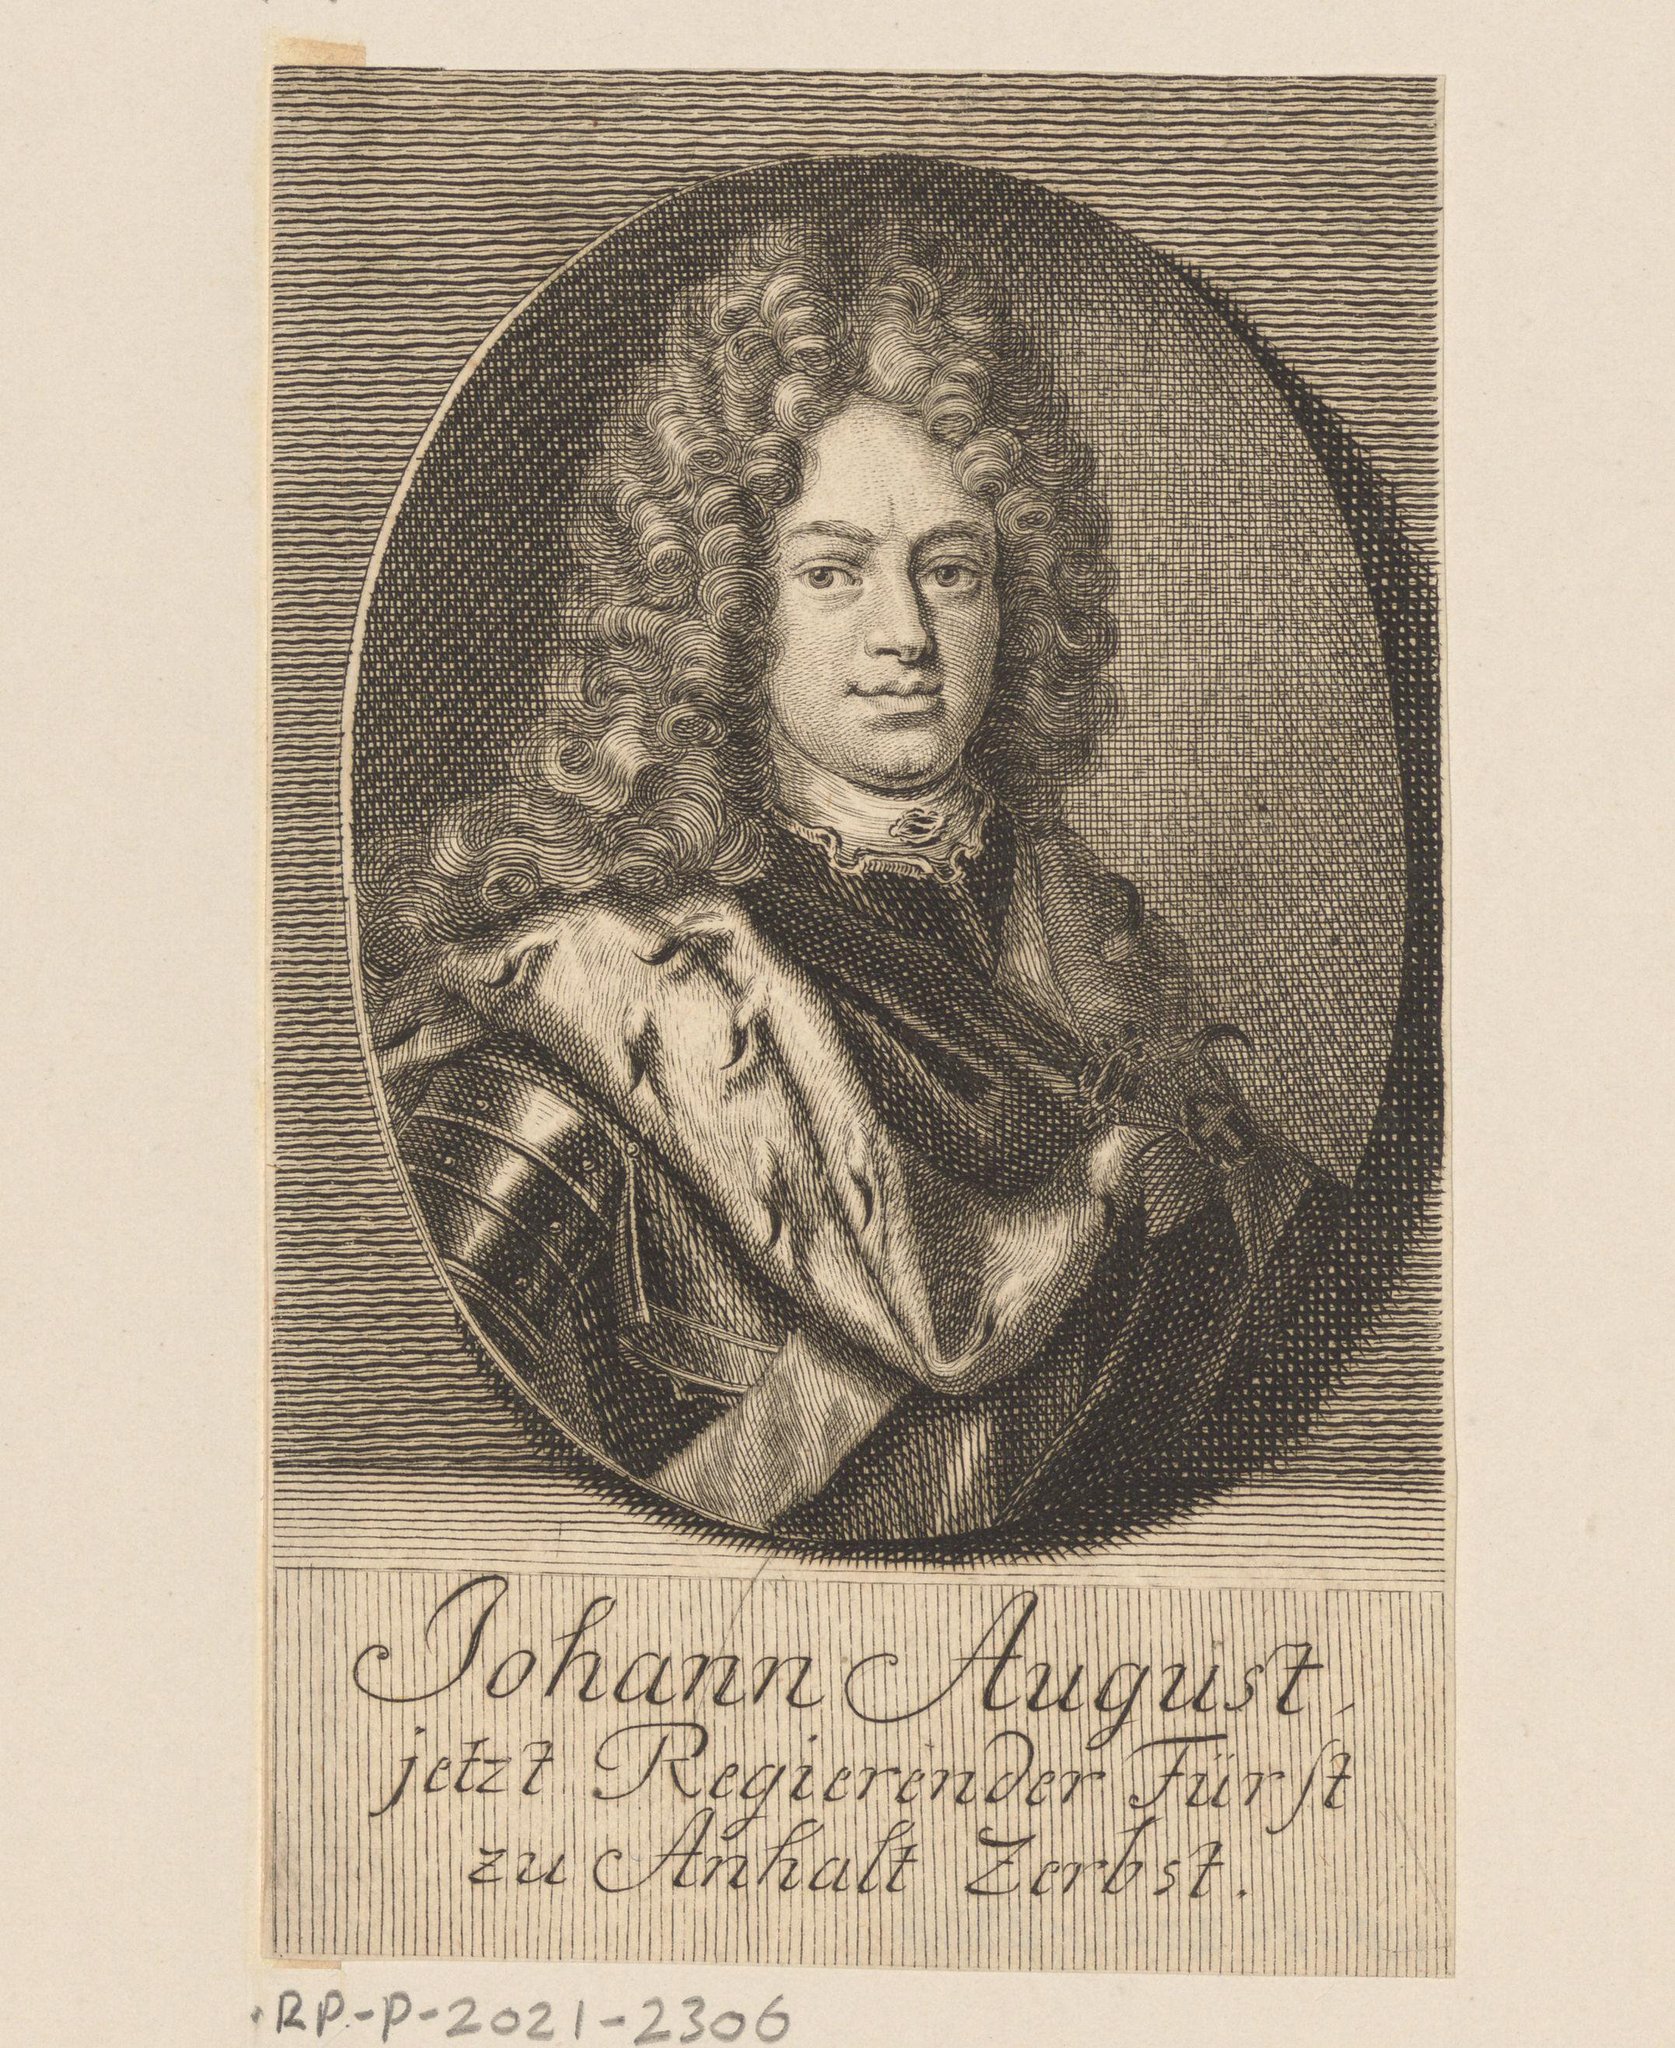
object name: print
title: Portret van Johann August von Anhalt-Zerbst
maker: Anonymous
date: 1718-1742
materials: paper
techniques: engraving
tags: historical persons, ruler, sovereign